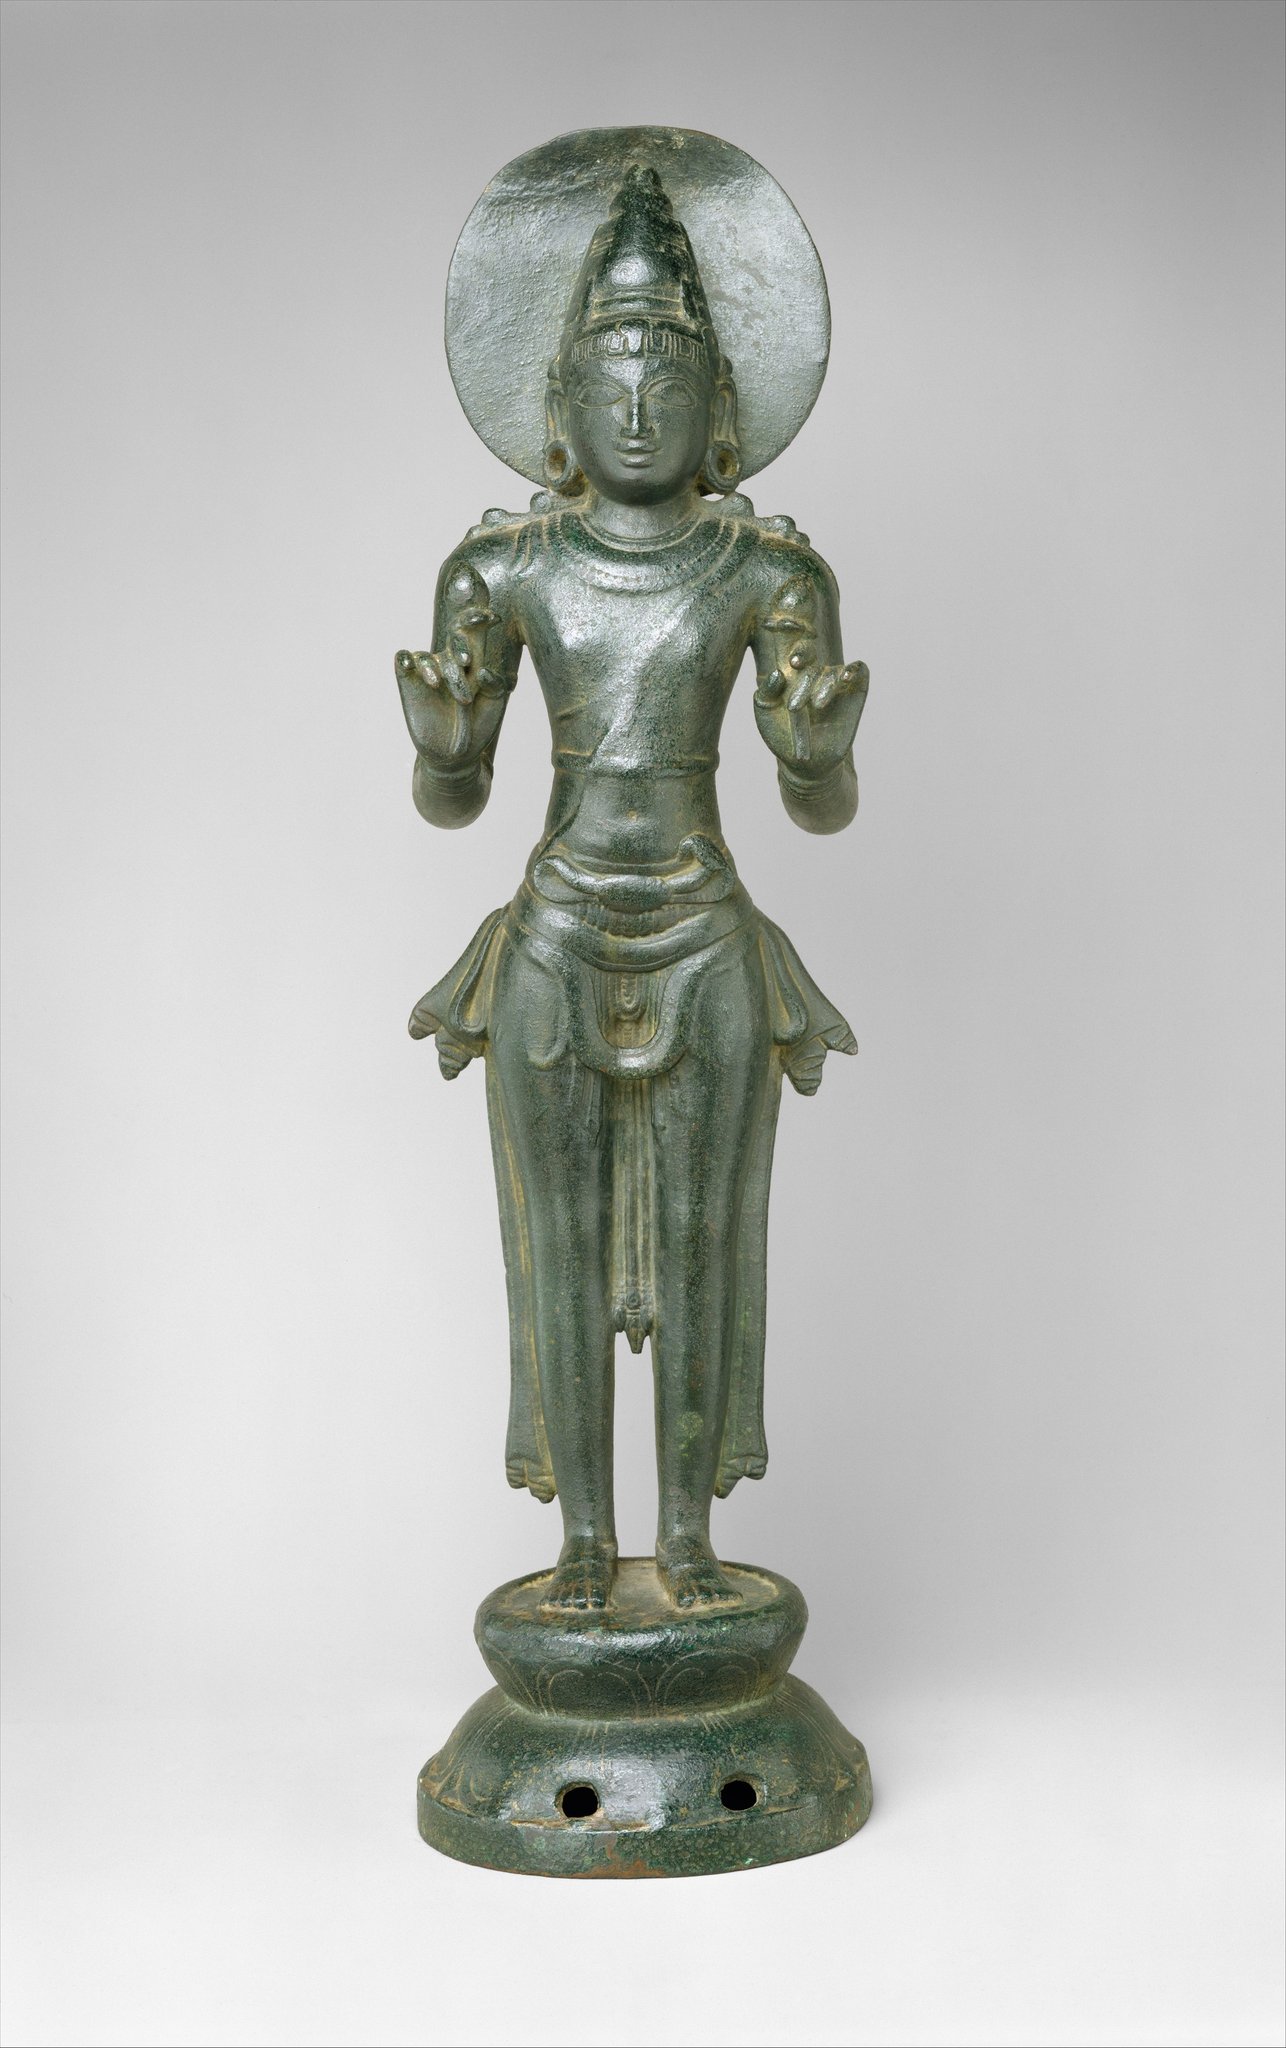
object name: figure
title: Standing Surya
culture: indian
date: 1001-1200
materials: copper alloy